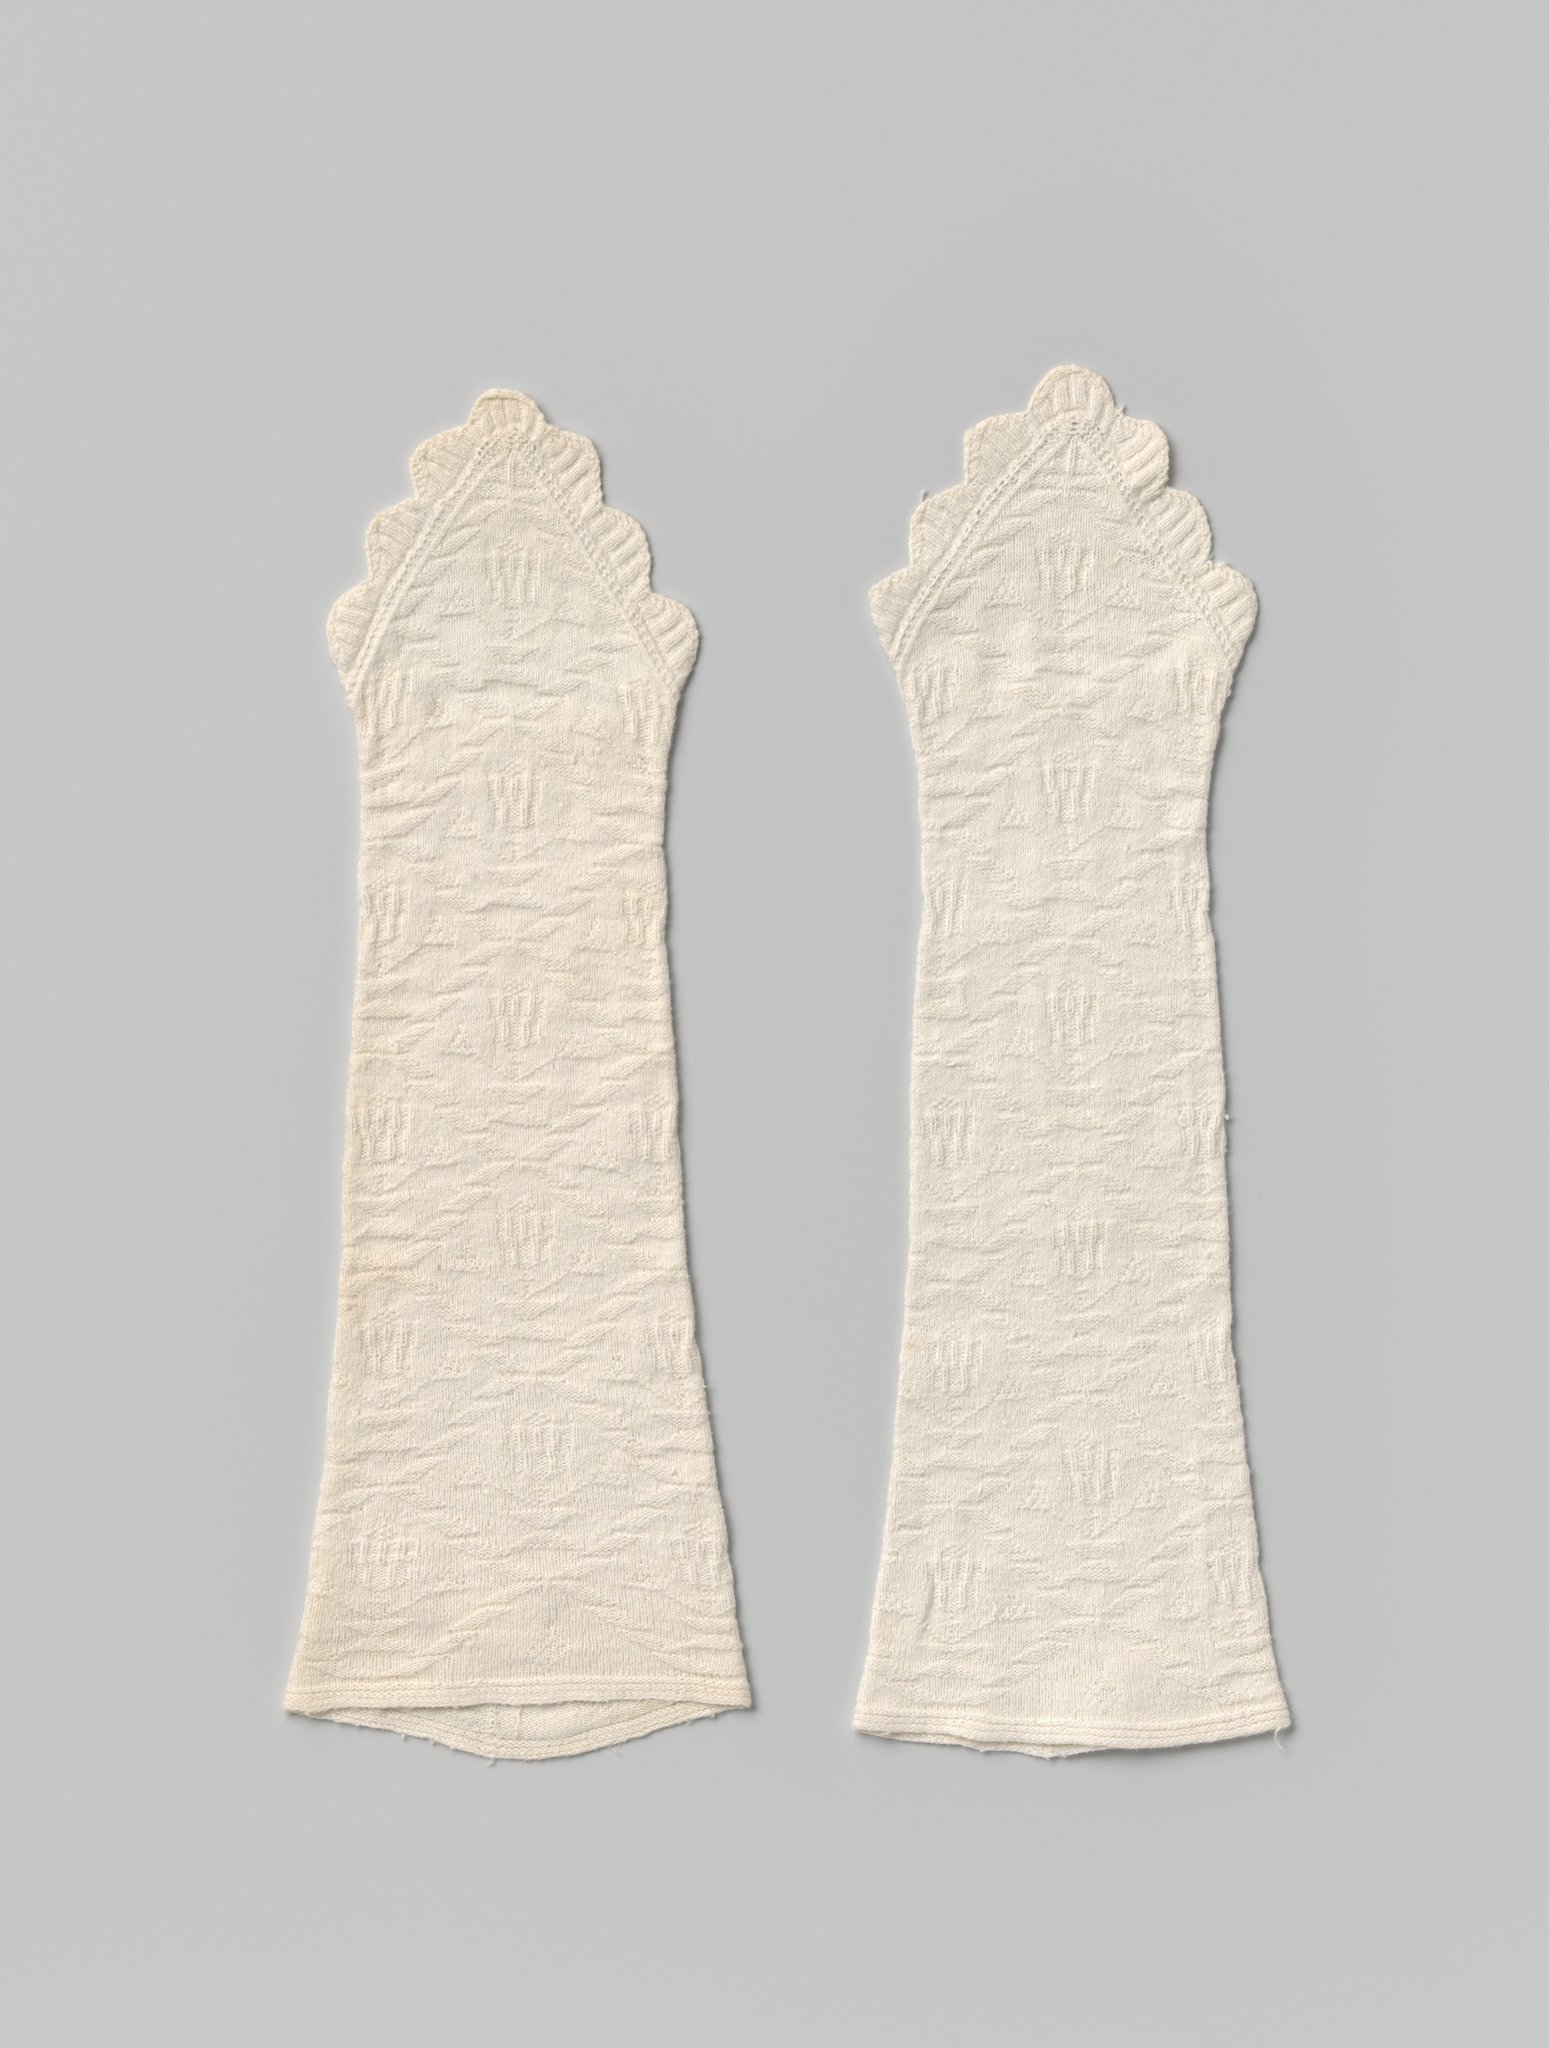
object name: clothing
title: Mitaine van witte gebreide katoen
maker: Anonymous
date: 1700-1750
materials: cotton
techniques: knitting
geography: netherlands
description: Mitaines van gebreid wit katoen, met gelijk ingebreid patroon van rasterwerk met grote bloem; het éne gemerkt ivm (of mm?), het andere met I. Model: Ellebooglang. Zonder duimen met driehoekig gedeelte dat over de handrug valt. Hieraan is een rand van schulpen gebreid. Er is één lengtenaad. Breipatroon: Rasterwerk, dat gevormd is van schuin boven elkaar staande dropjes, is telkens gevuld, met een diabolo-vormige vaas, waarin een grote tulp aan korte steel staat, tussen twee blaadjes. De merken zijn in wit in een maasteek opgeborduurd.